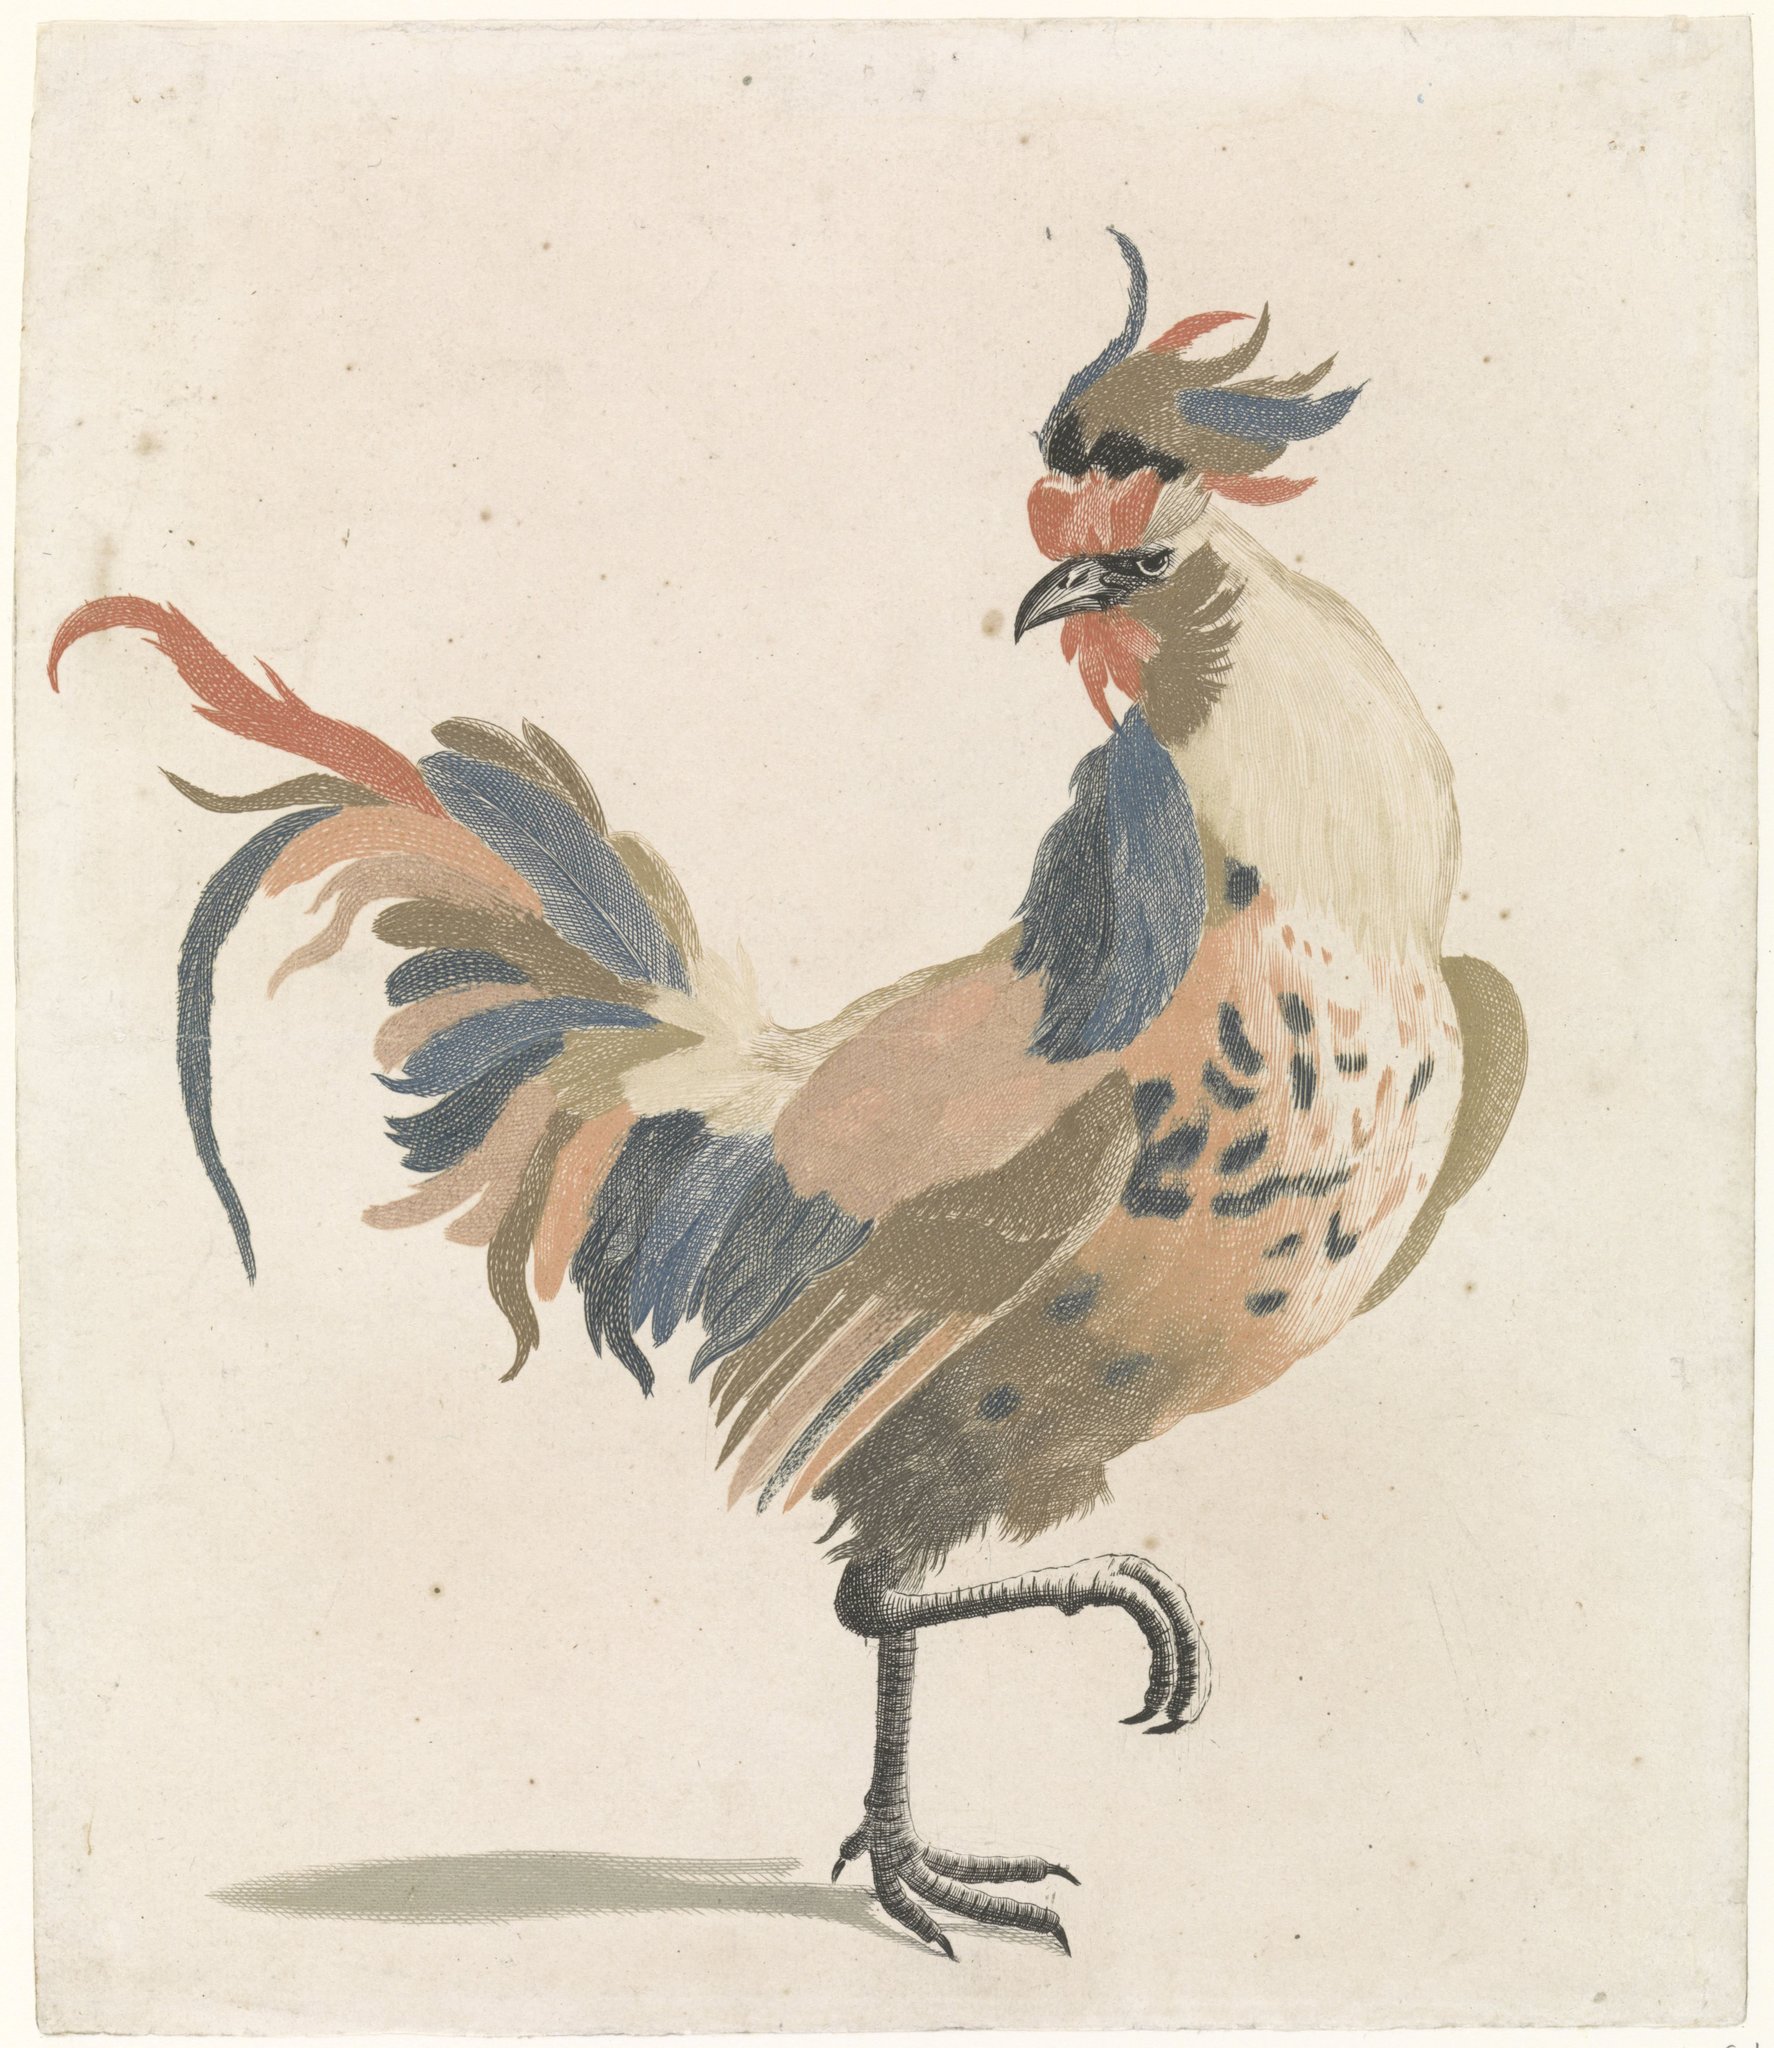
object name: print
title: Haan lopend naar rechts (versie A)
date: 1688-1698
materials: paper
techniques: printing, engraving, lithography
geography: netherlands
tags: fowl (cock, hen, chicken, etc.)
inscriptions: collector's mark: Lugt 2228, collector's mark: Lugt 2760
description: Haan, lopend naar rechts, omkijkend naar links.